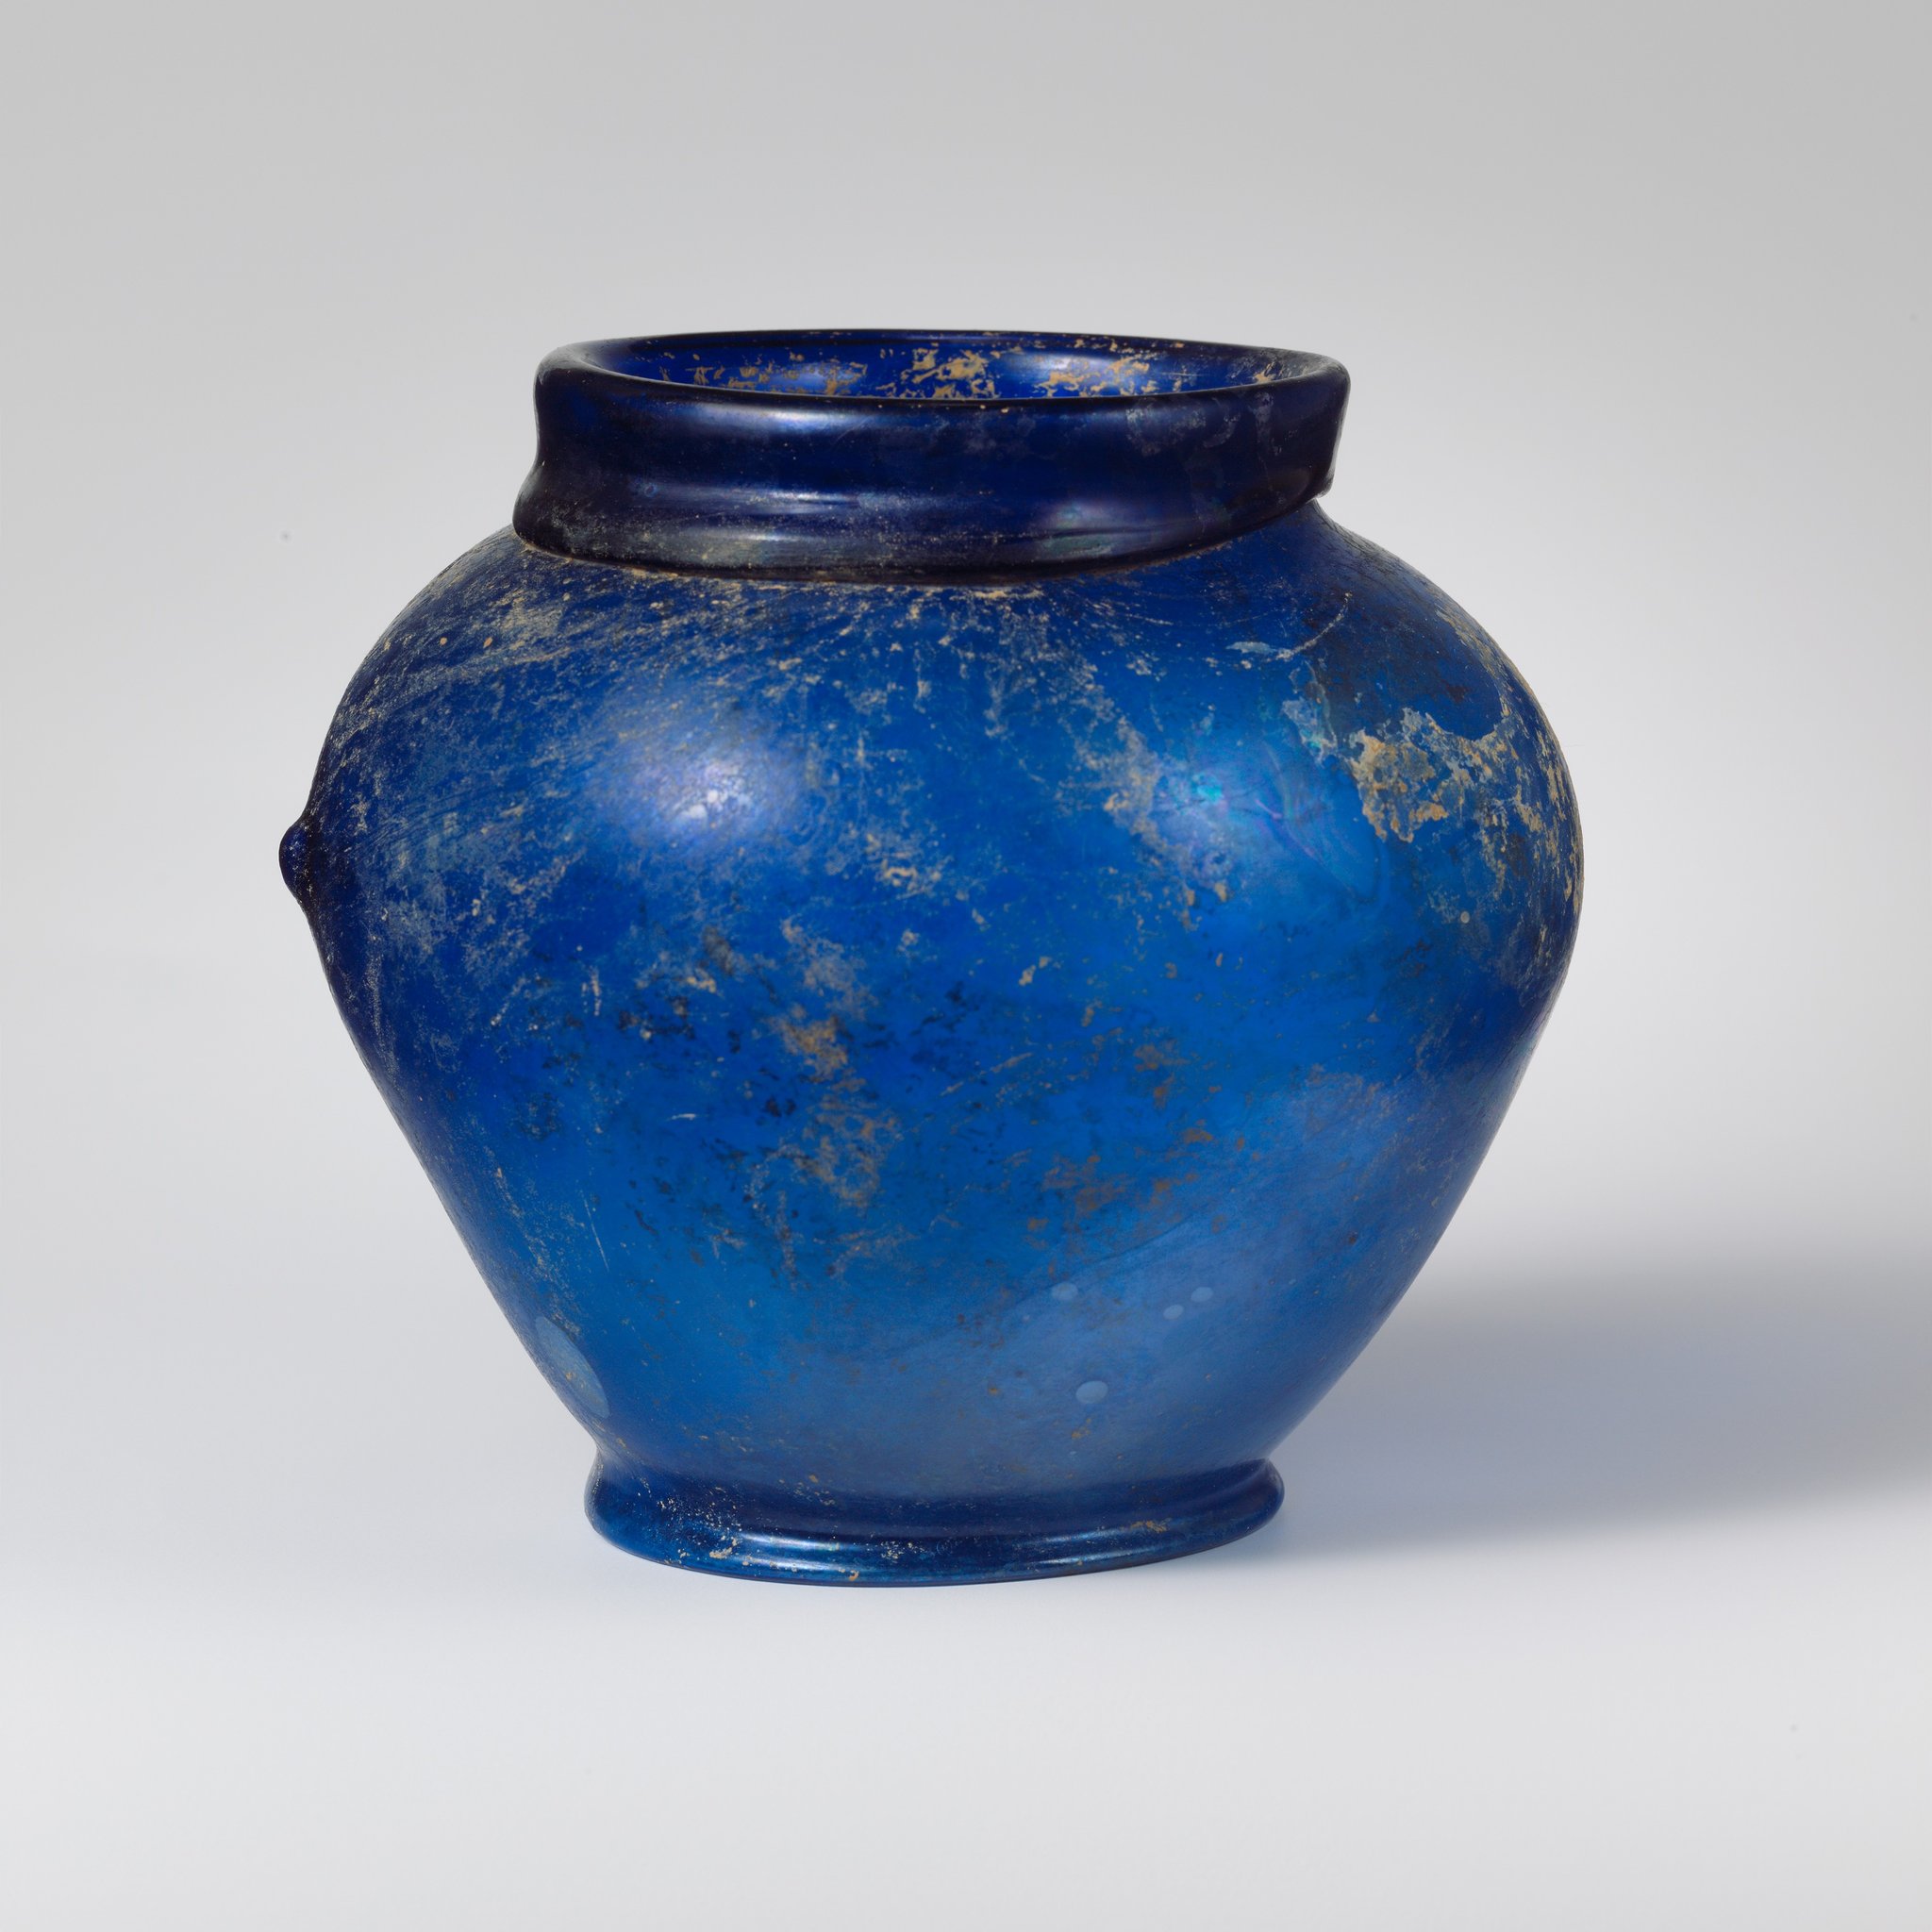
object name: jar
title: Glass jar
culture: roman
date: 1-100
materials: glass